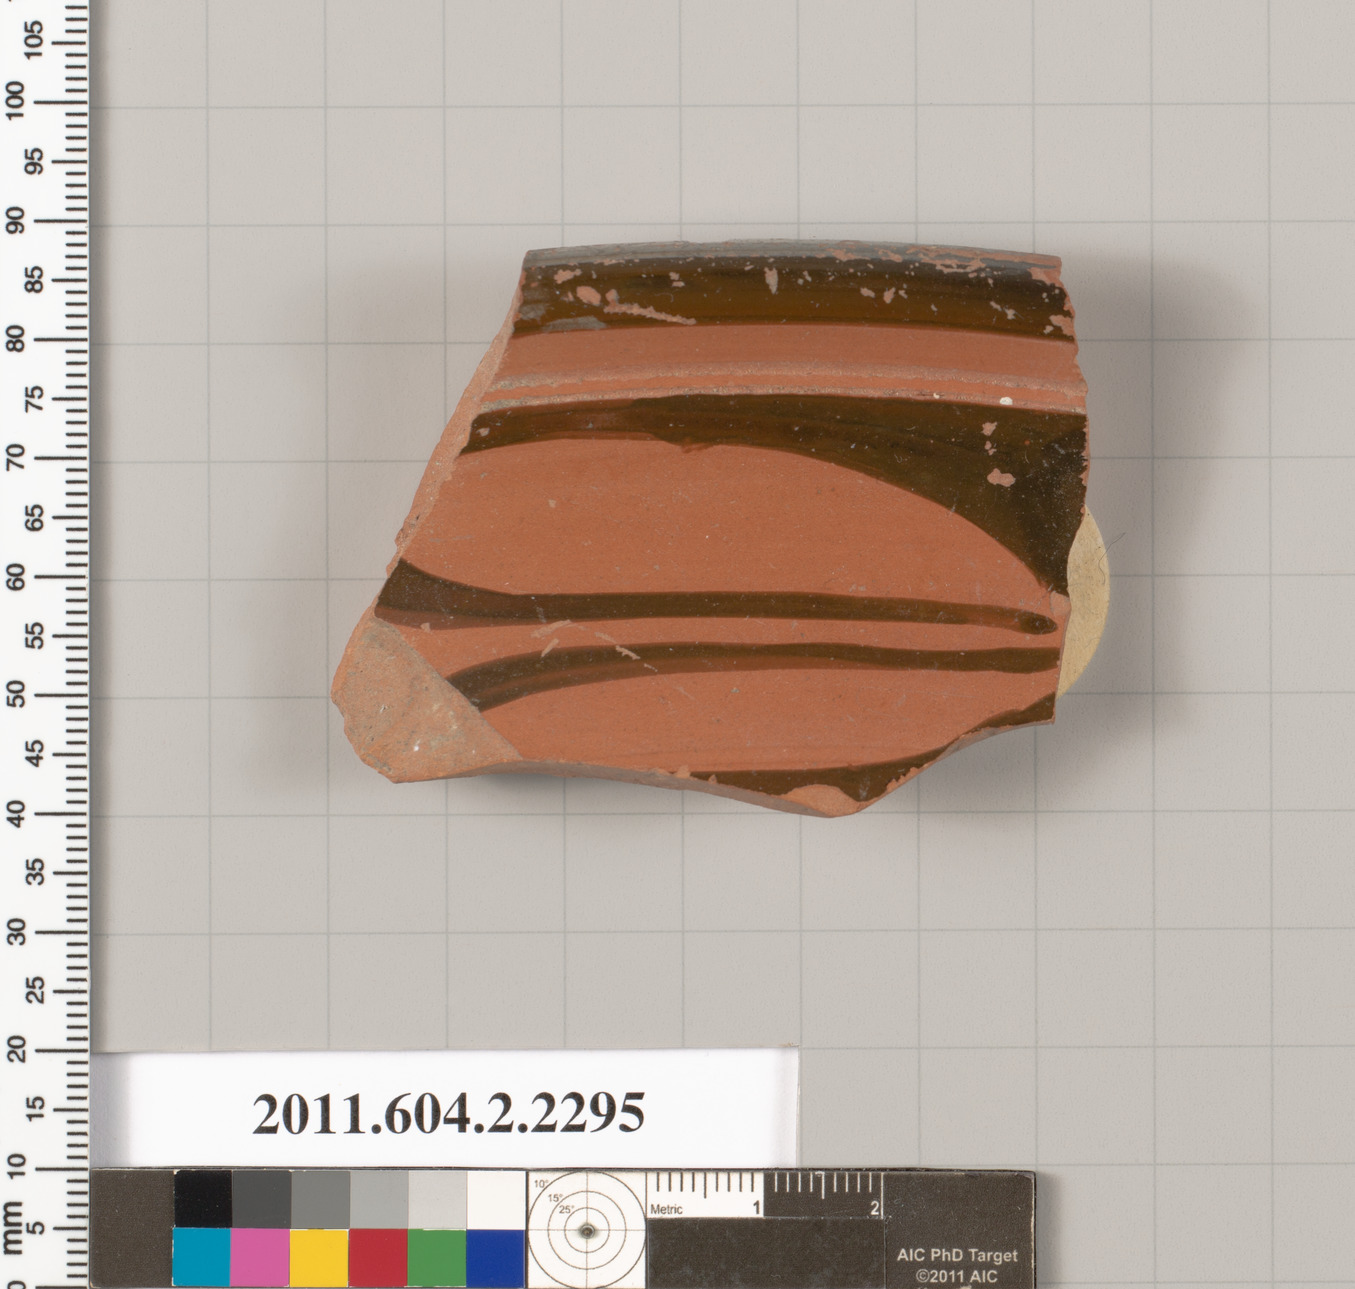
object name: bell krater fragment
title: Terracotta fragment of a bell-krater (bowl for mixing wine and water)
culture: greek, attic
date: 460-440 BCE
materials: terracotta